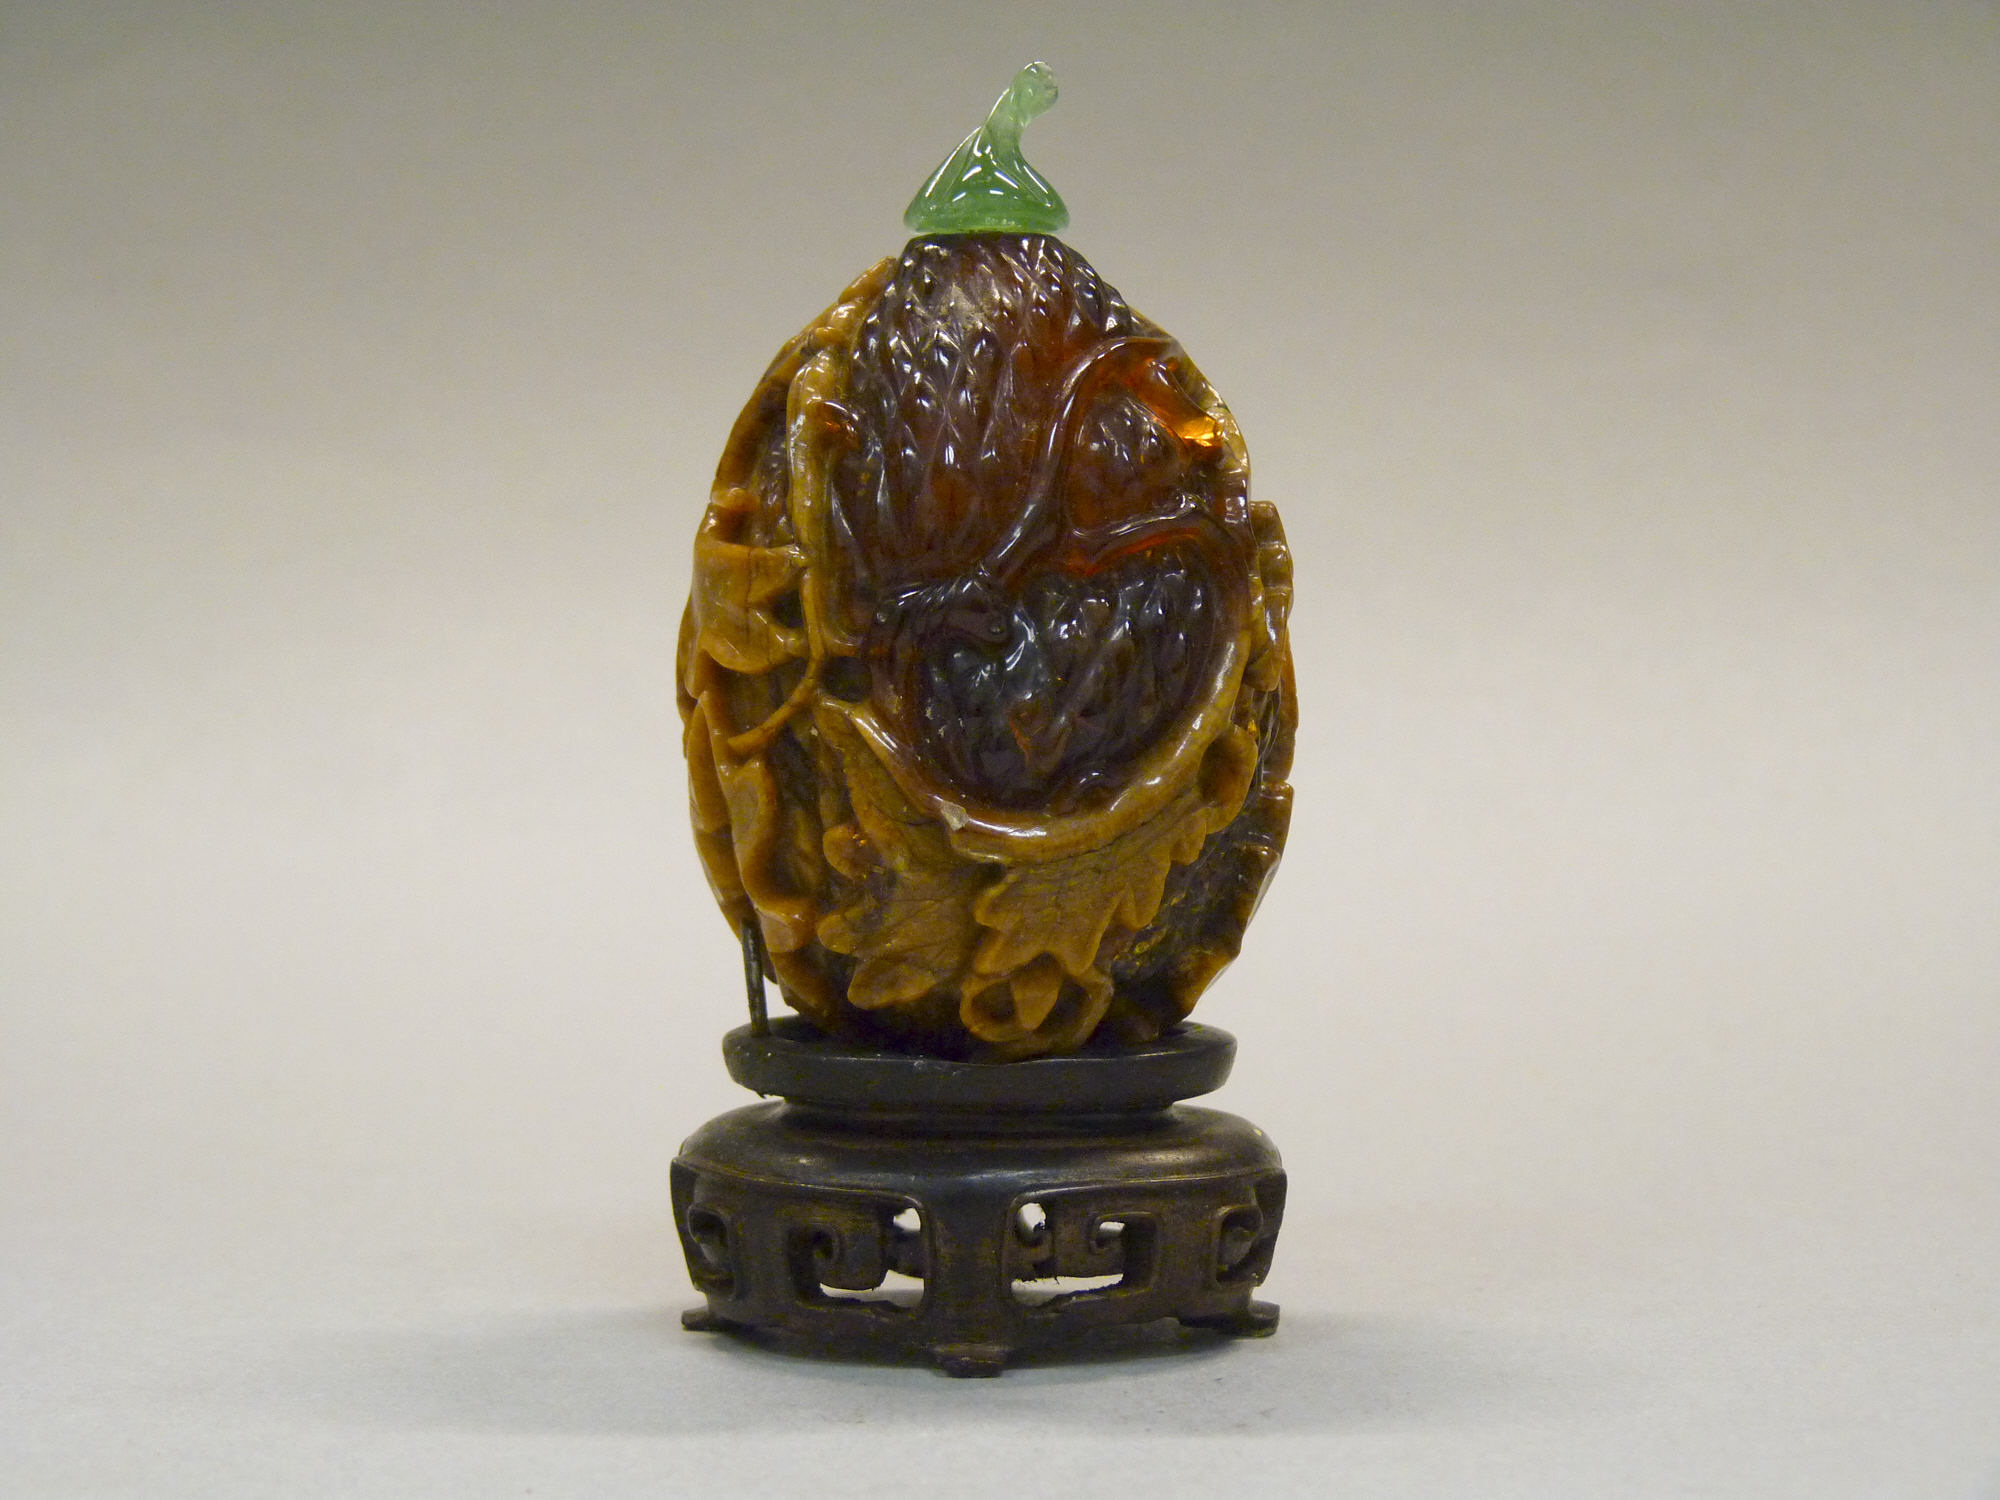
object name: snuff bottle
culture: chinese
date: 1801-1900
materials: amber, glass, wood